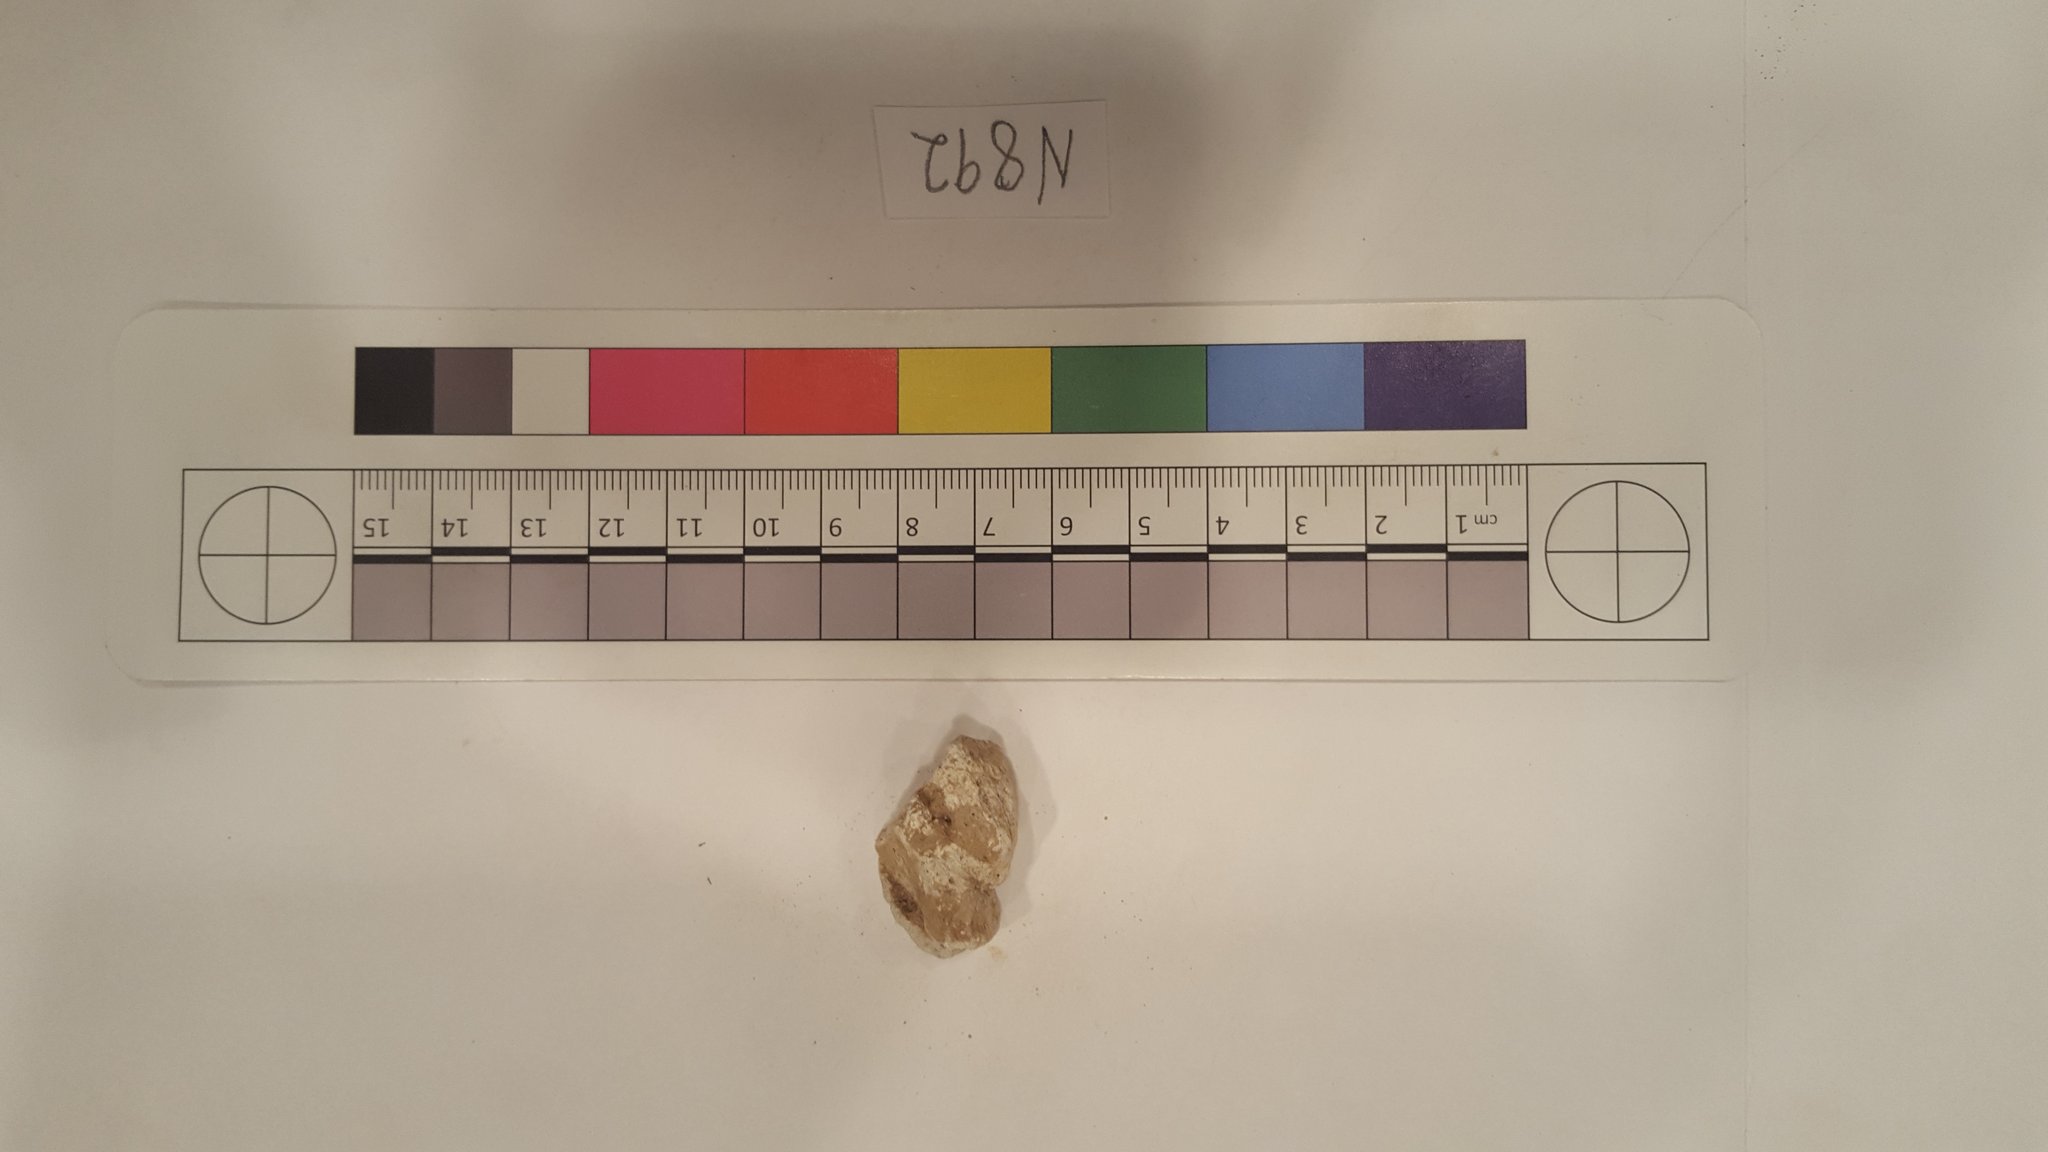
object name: fragment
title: Stucco Fragment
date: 701-1200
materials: plaster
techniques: carving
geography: iran